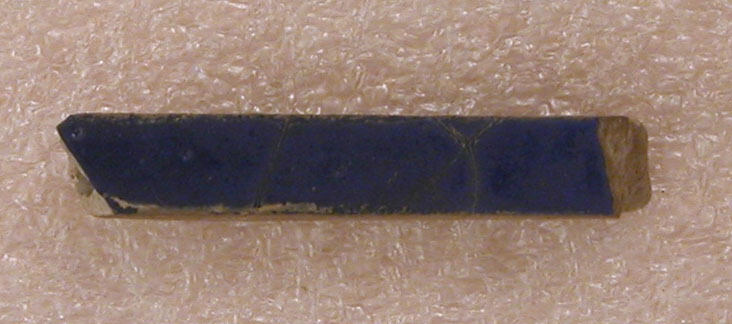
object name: tile fragment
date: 1334-1434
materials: stonepaste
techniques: glazing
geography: uzbekistan